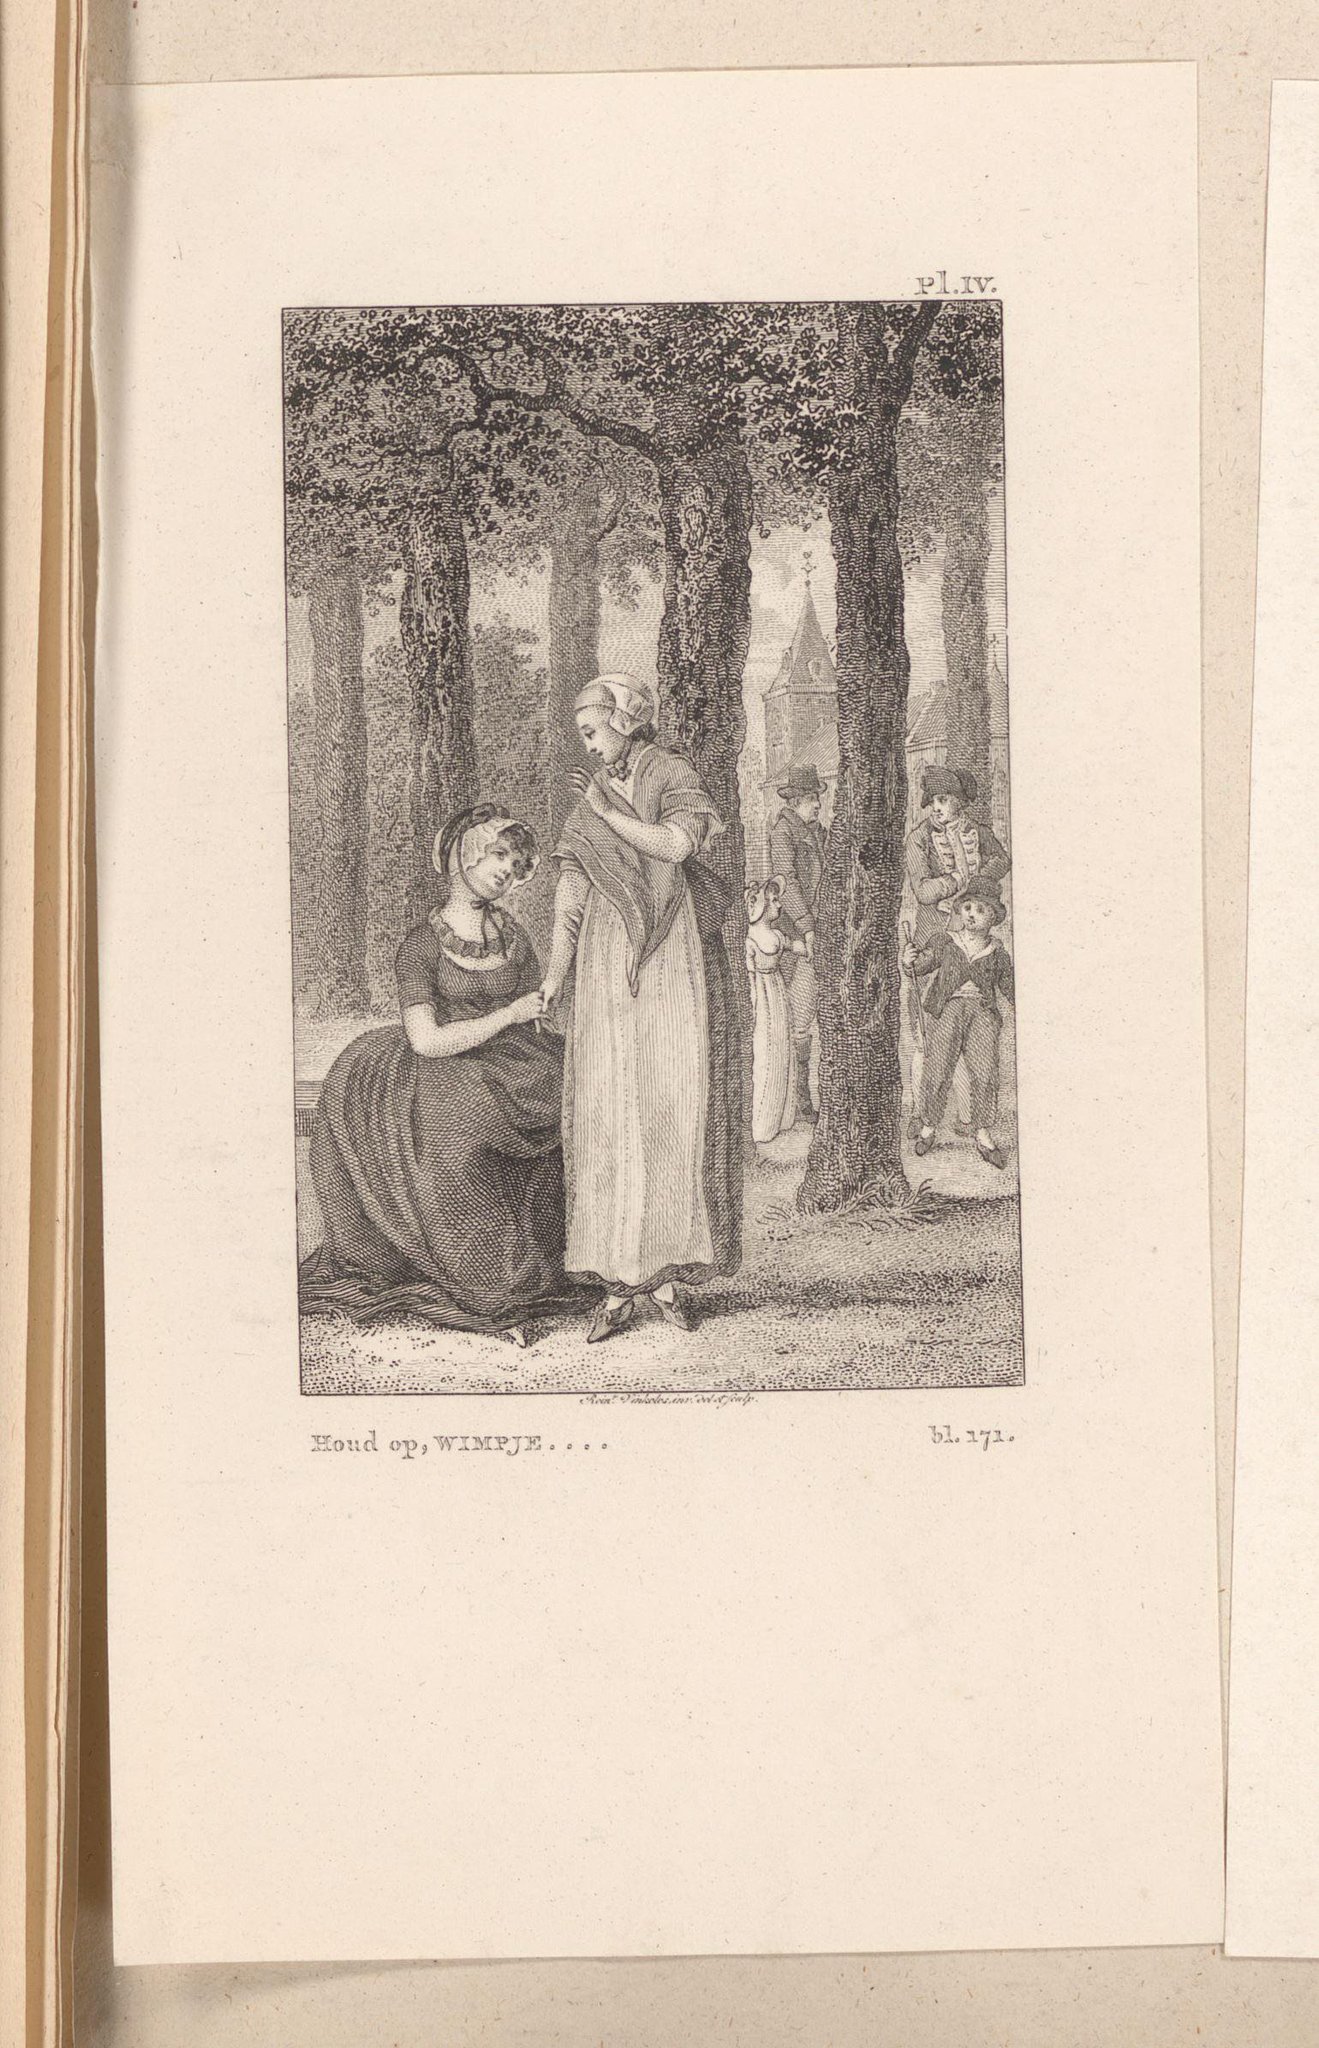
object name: book illustration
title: Clara vraagt Wilhelmina om verder te gaan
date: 1804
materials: paper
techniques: engraving, etching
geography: haarlem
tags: castle, forest, wood, family, descendance, conversation, dialogue; conversation piece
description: Gebruikt als boekillustratie in: Loosjes, Adriaan Pietersz. Zedelijke Verhaalen. Haarlem: Adriaan Loosjes, 1804-1805. Tweede druk Haarlem: Adriaan Loosjes, 1815.